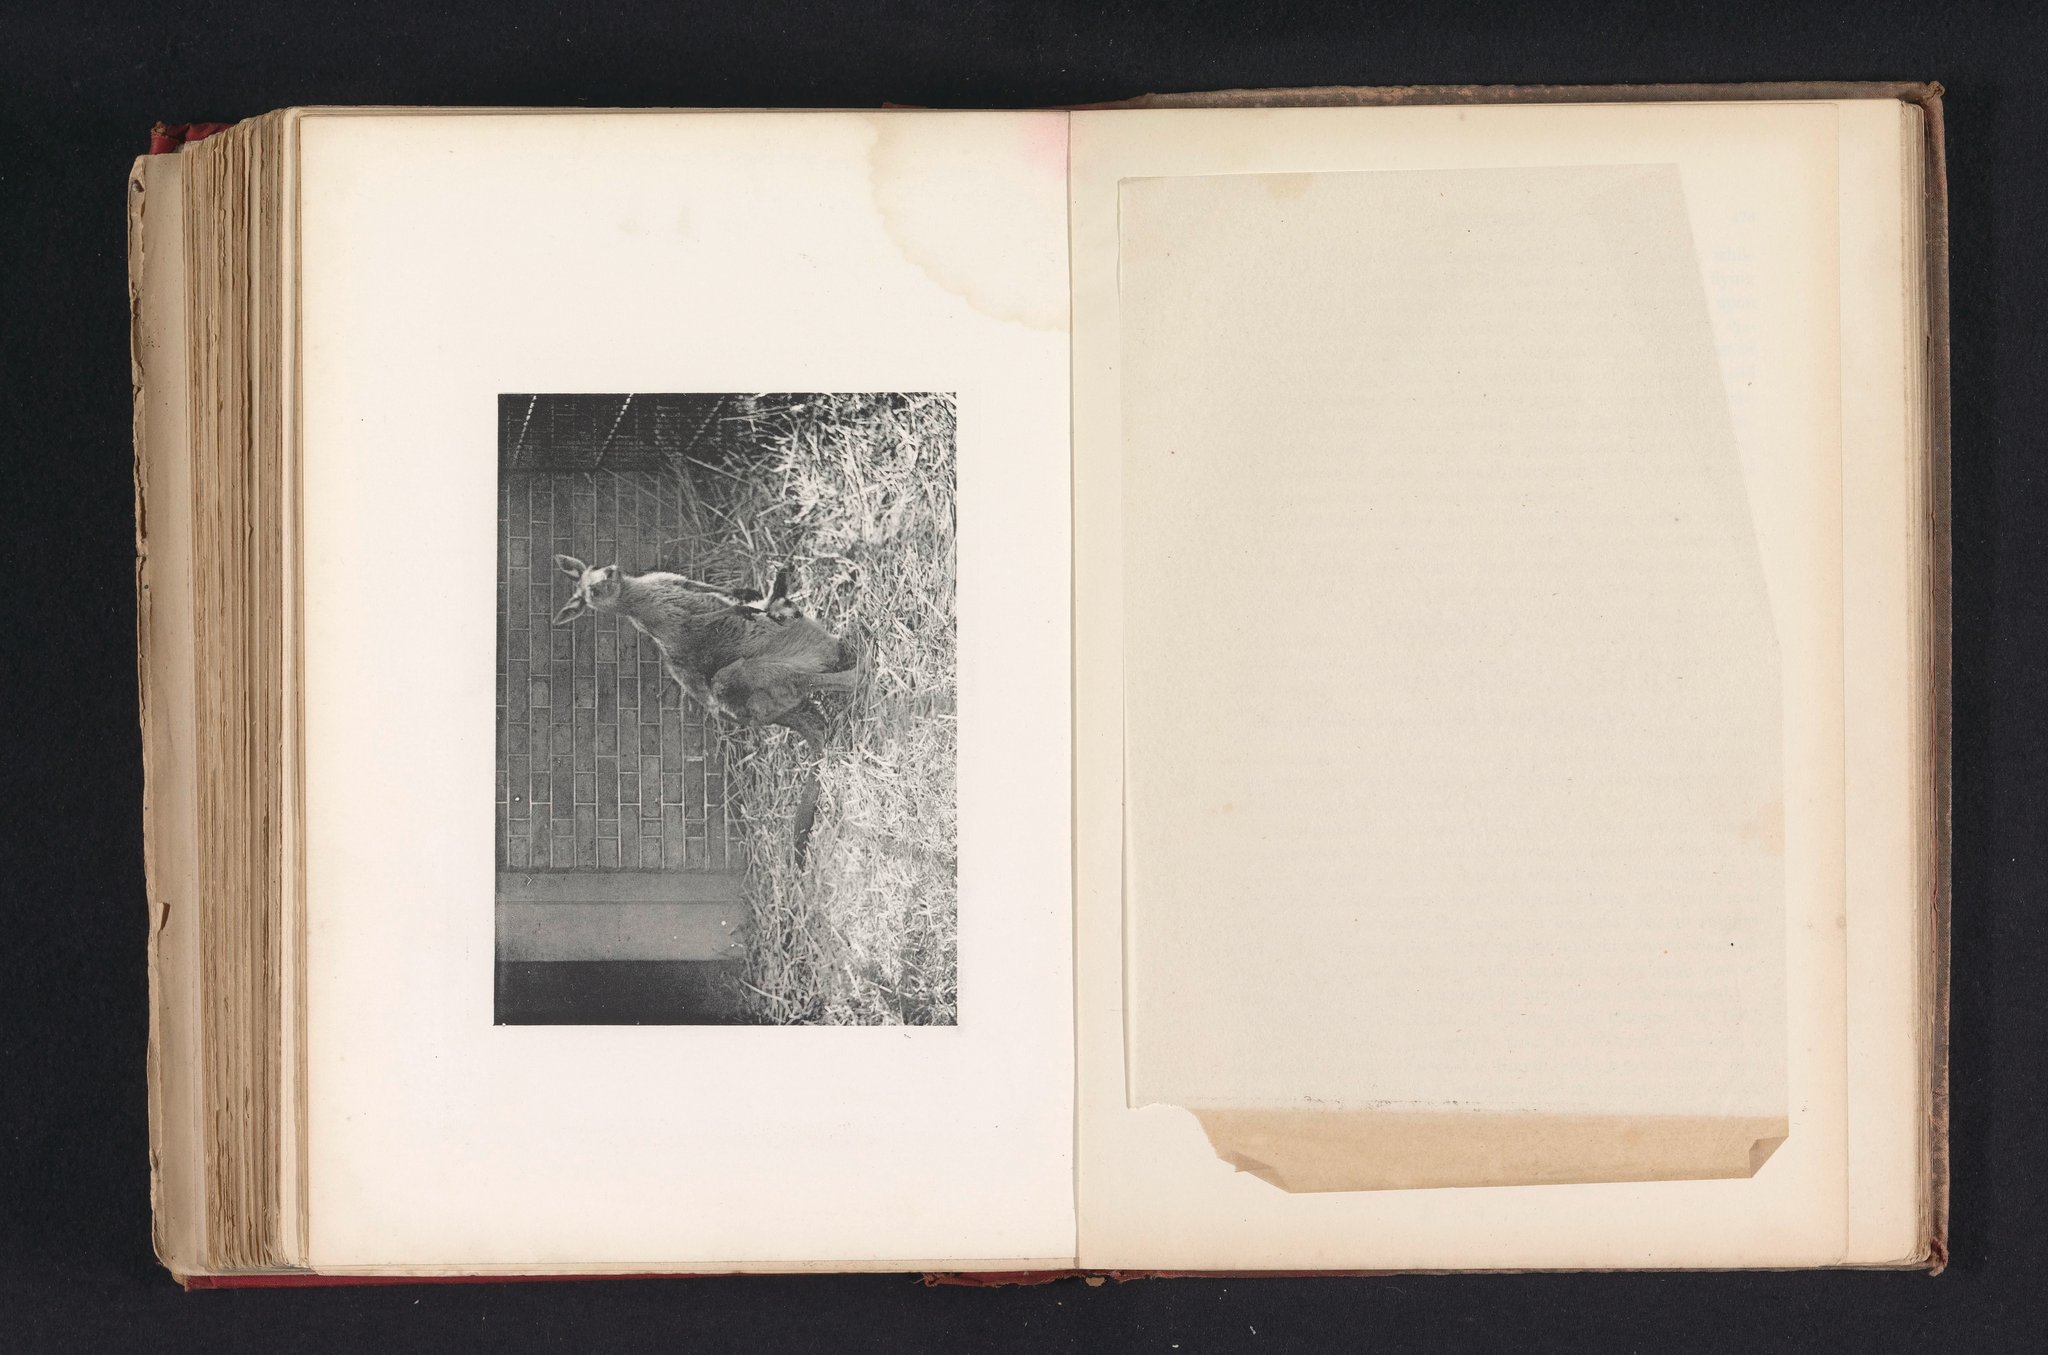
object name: photomechanical print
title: A kangaroo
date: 1876-1886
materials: paper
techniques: photograph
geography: paris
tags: other mammals (with name), zoological garden, zoo, seen as place where non-domestic animals are kept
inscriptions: inscription: ‘A female animal with the young one peering out from the pouch.’